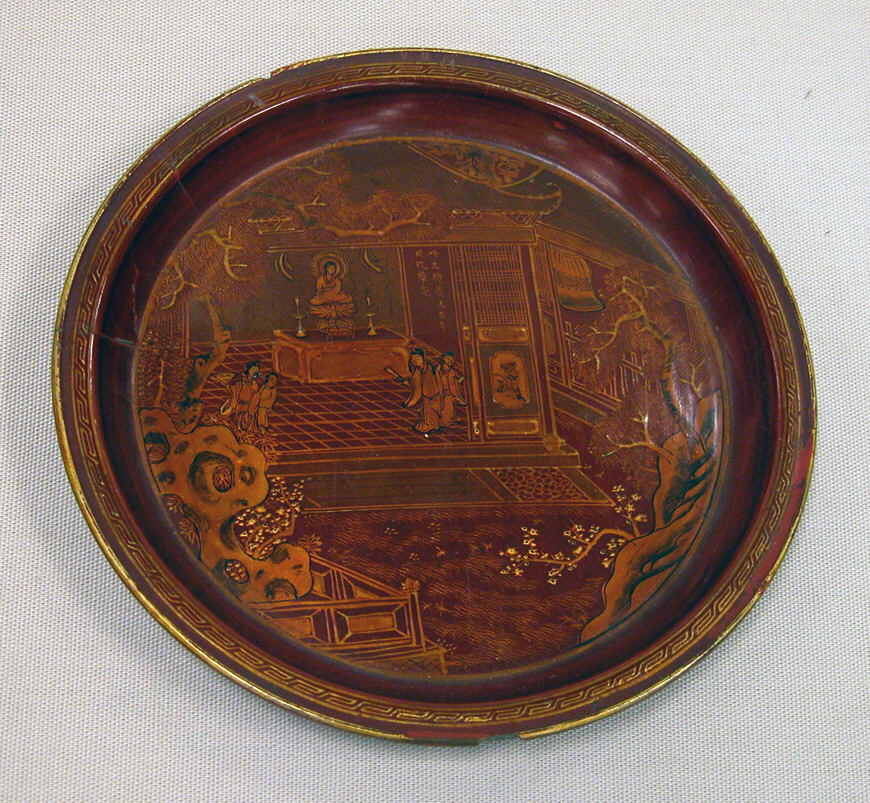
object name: tray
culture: chinese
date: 1701-1800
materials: lacquer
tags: human figures,interiors